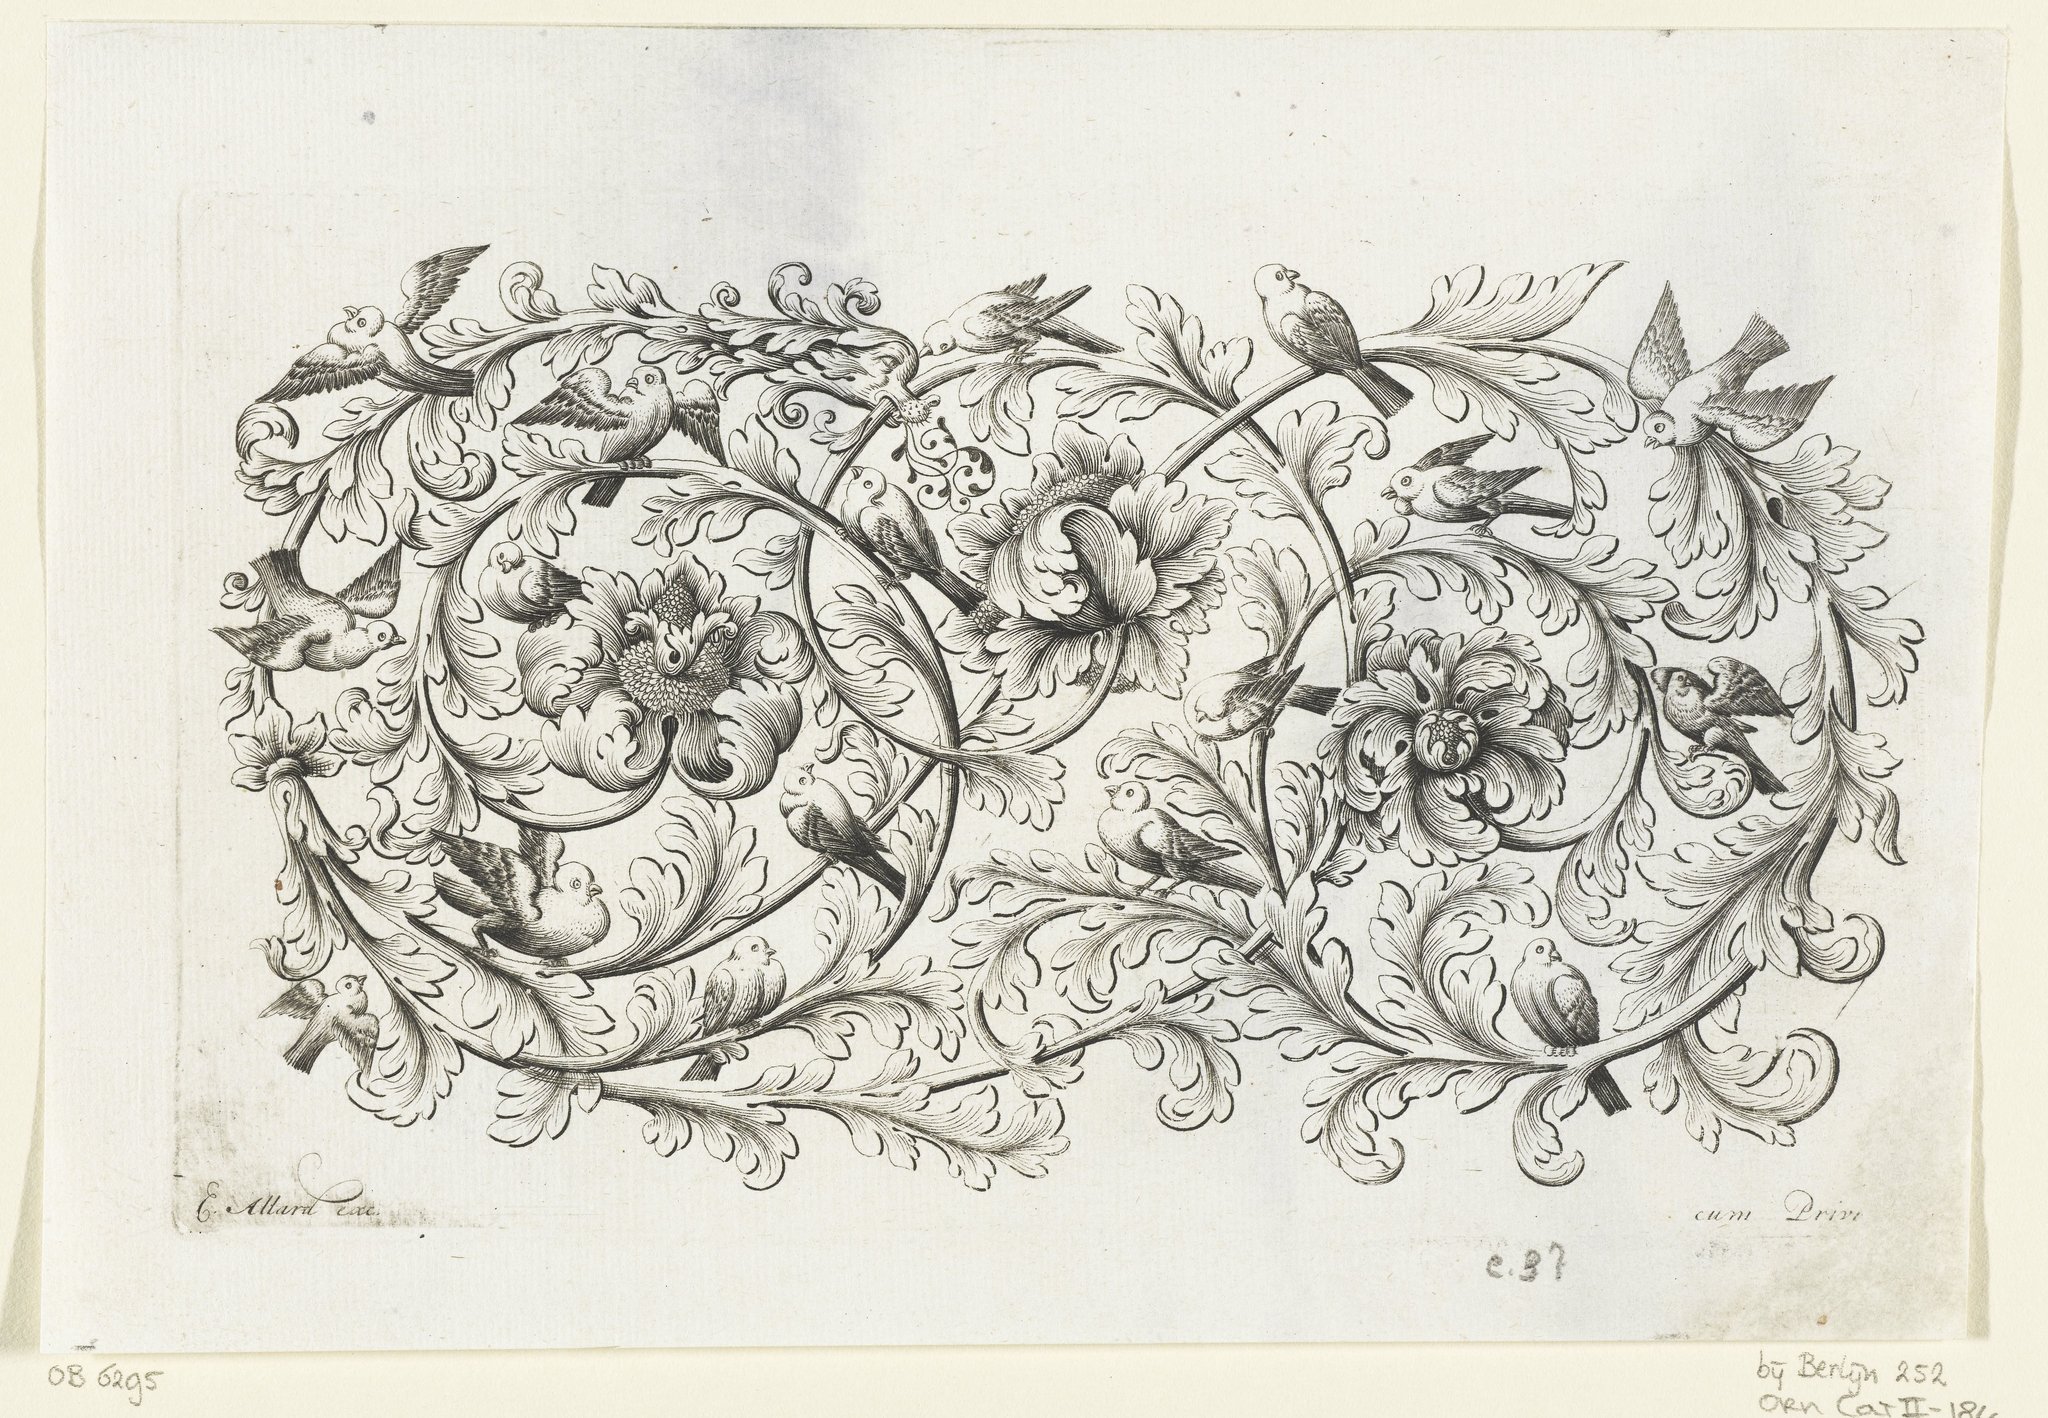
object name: ornament print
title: Ornamenten voor zilversmeden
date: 1690-1700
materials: paper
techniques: engraving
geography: amsterdam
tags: ornament derived from plant forms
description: Blad uit derde serie van 6 bladen met voorbeelden van ornamenten voor zilversmeden.